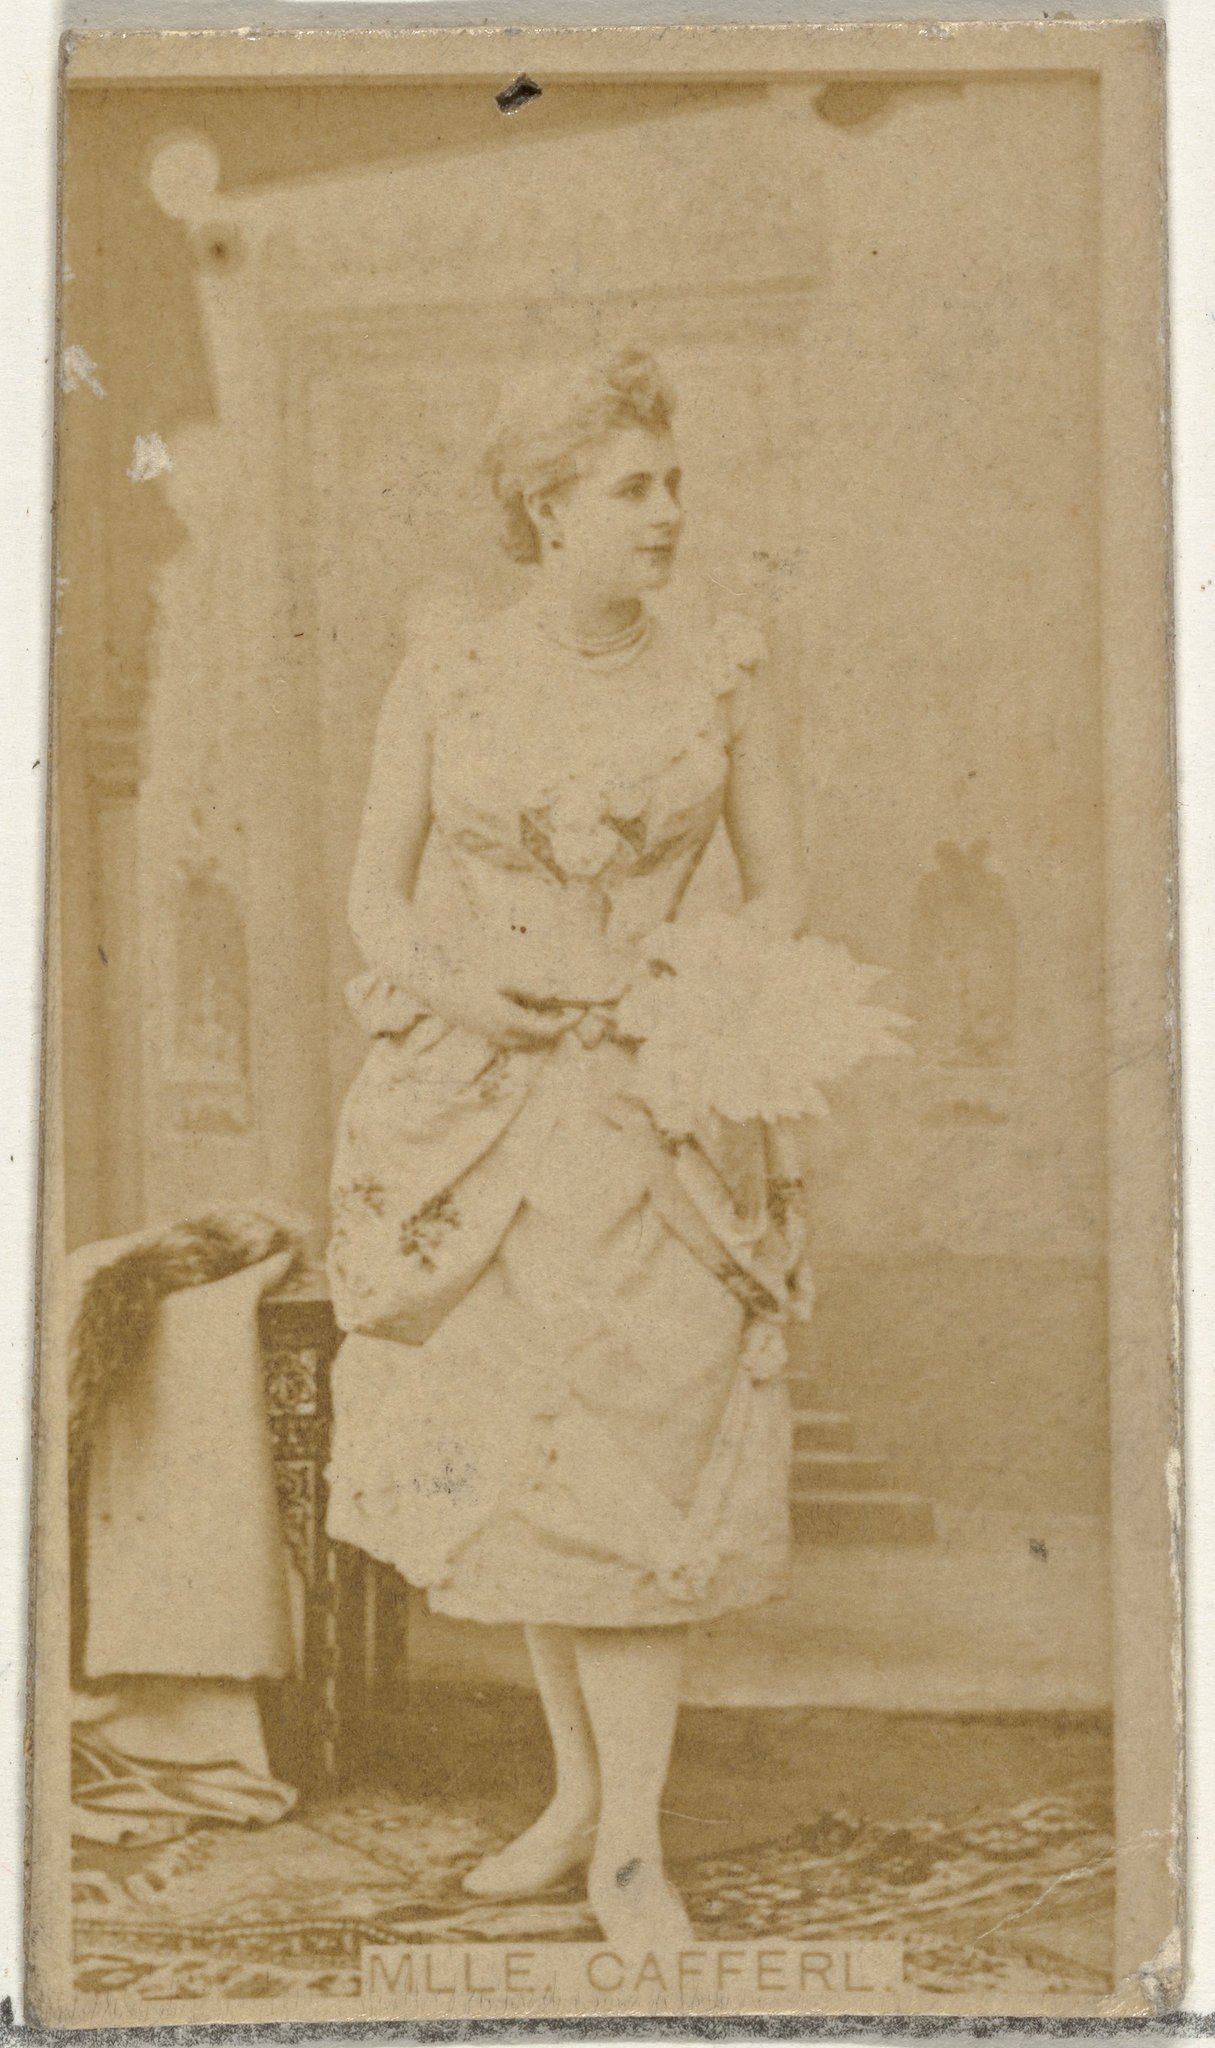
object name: photograph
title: Mlle. Cafferl, from the Actors and Actresses series (N145-8) issued by Duke Sons & Co. to promote Duke Cigarettes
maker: w. duke, sons & co.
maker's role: publisher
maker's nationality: american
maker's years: 1870-1920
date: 1891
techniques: albumen silver print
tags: portraits,women,actresses